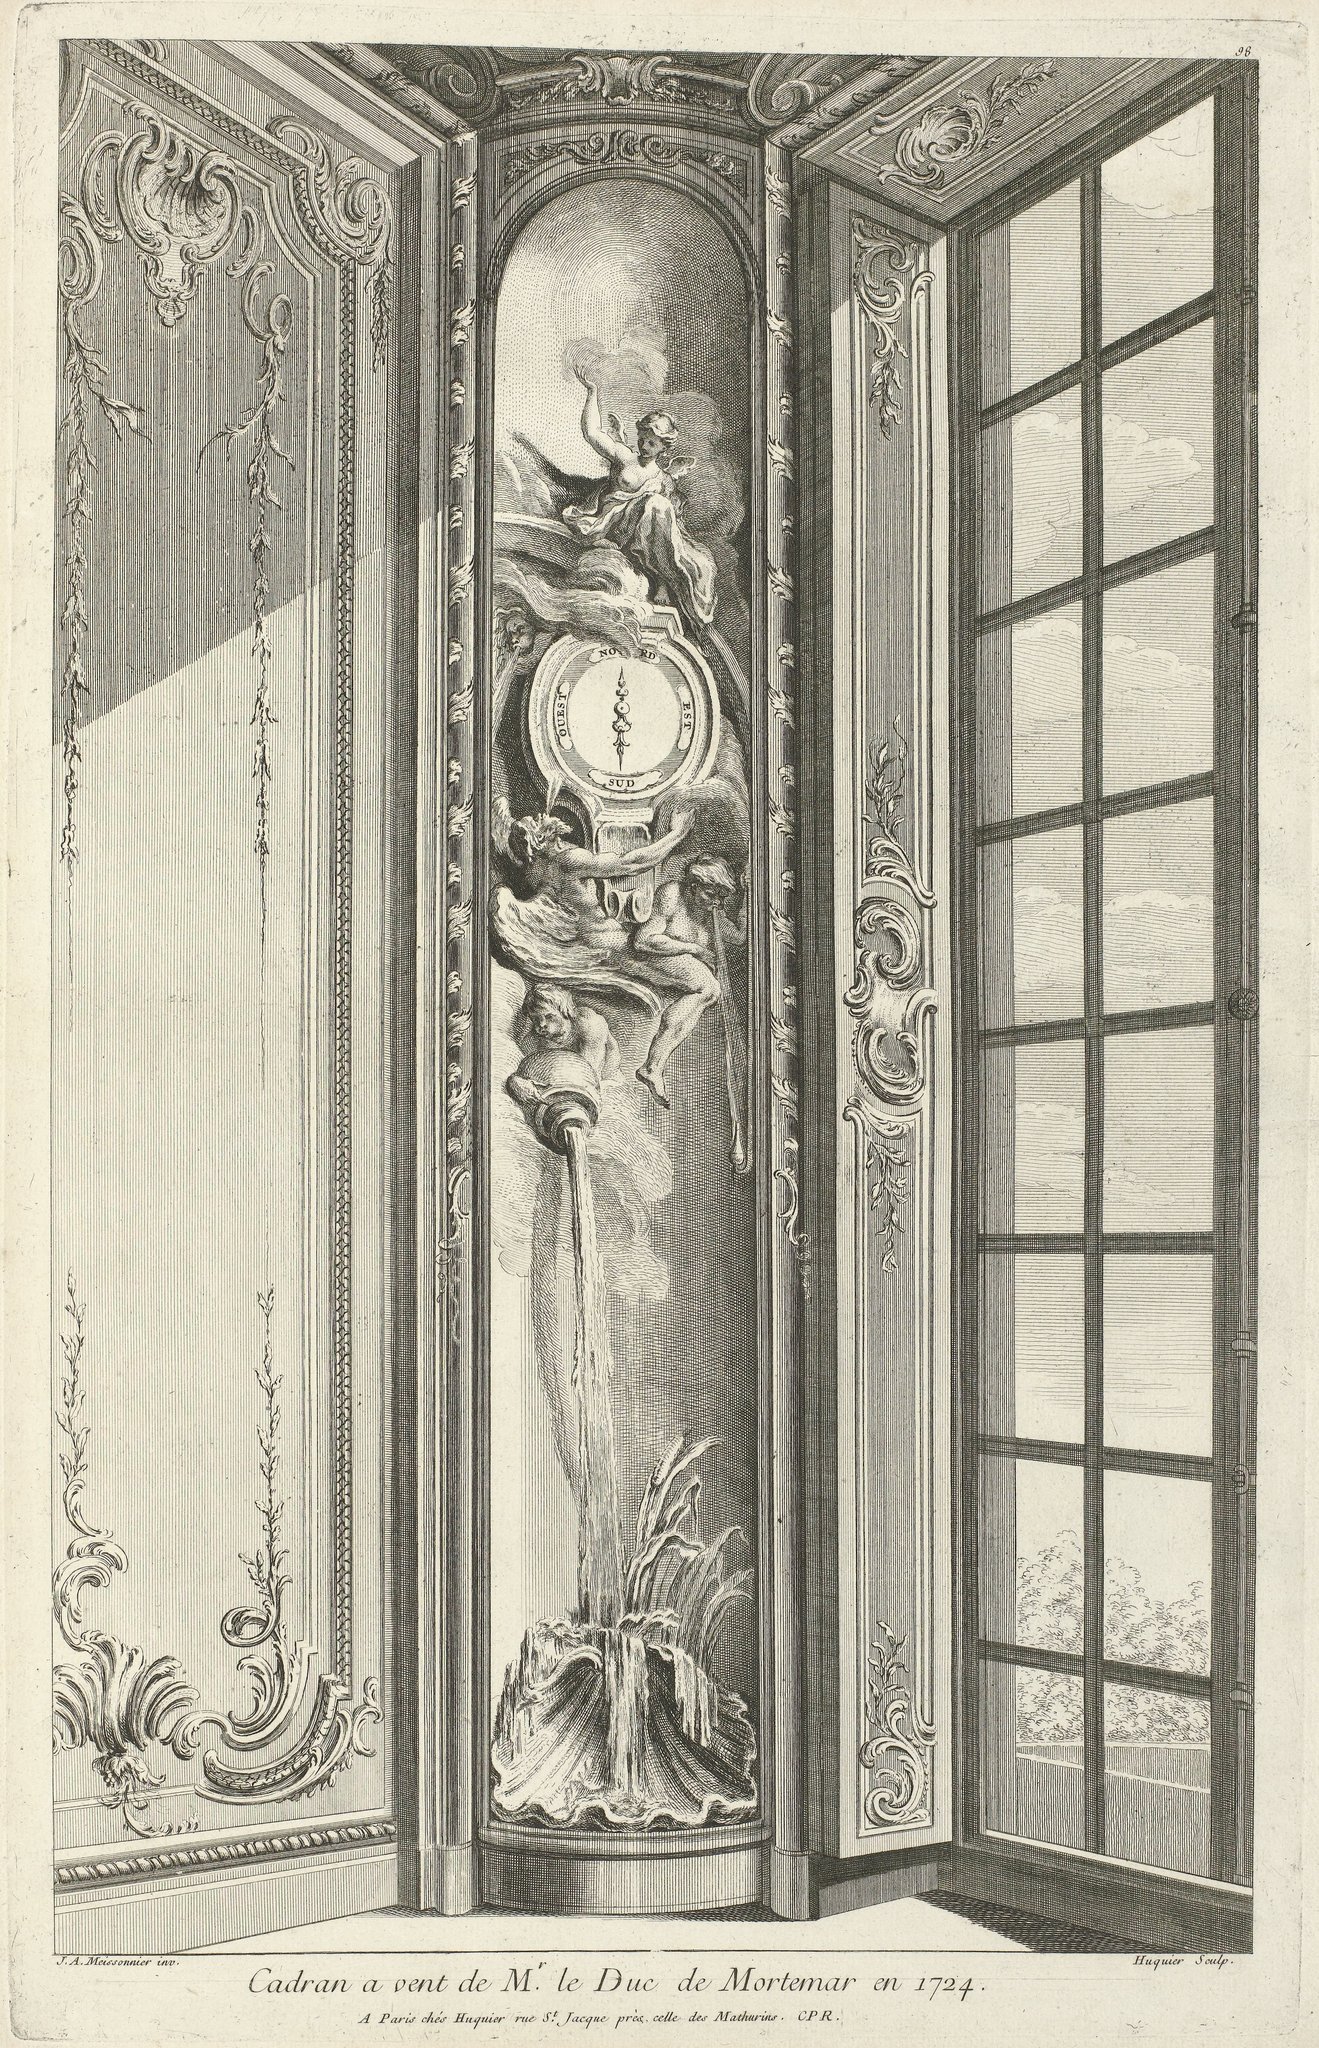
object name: album leaf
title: Oeuvre van Juste Aurele Meissonnier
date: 1738-1749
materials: paper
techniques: etching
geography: paris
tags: weather-vane, work of applied art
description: Deze prent maakt deel uit van een album.